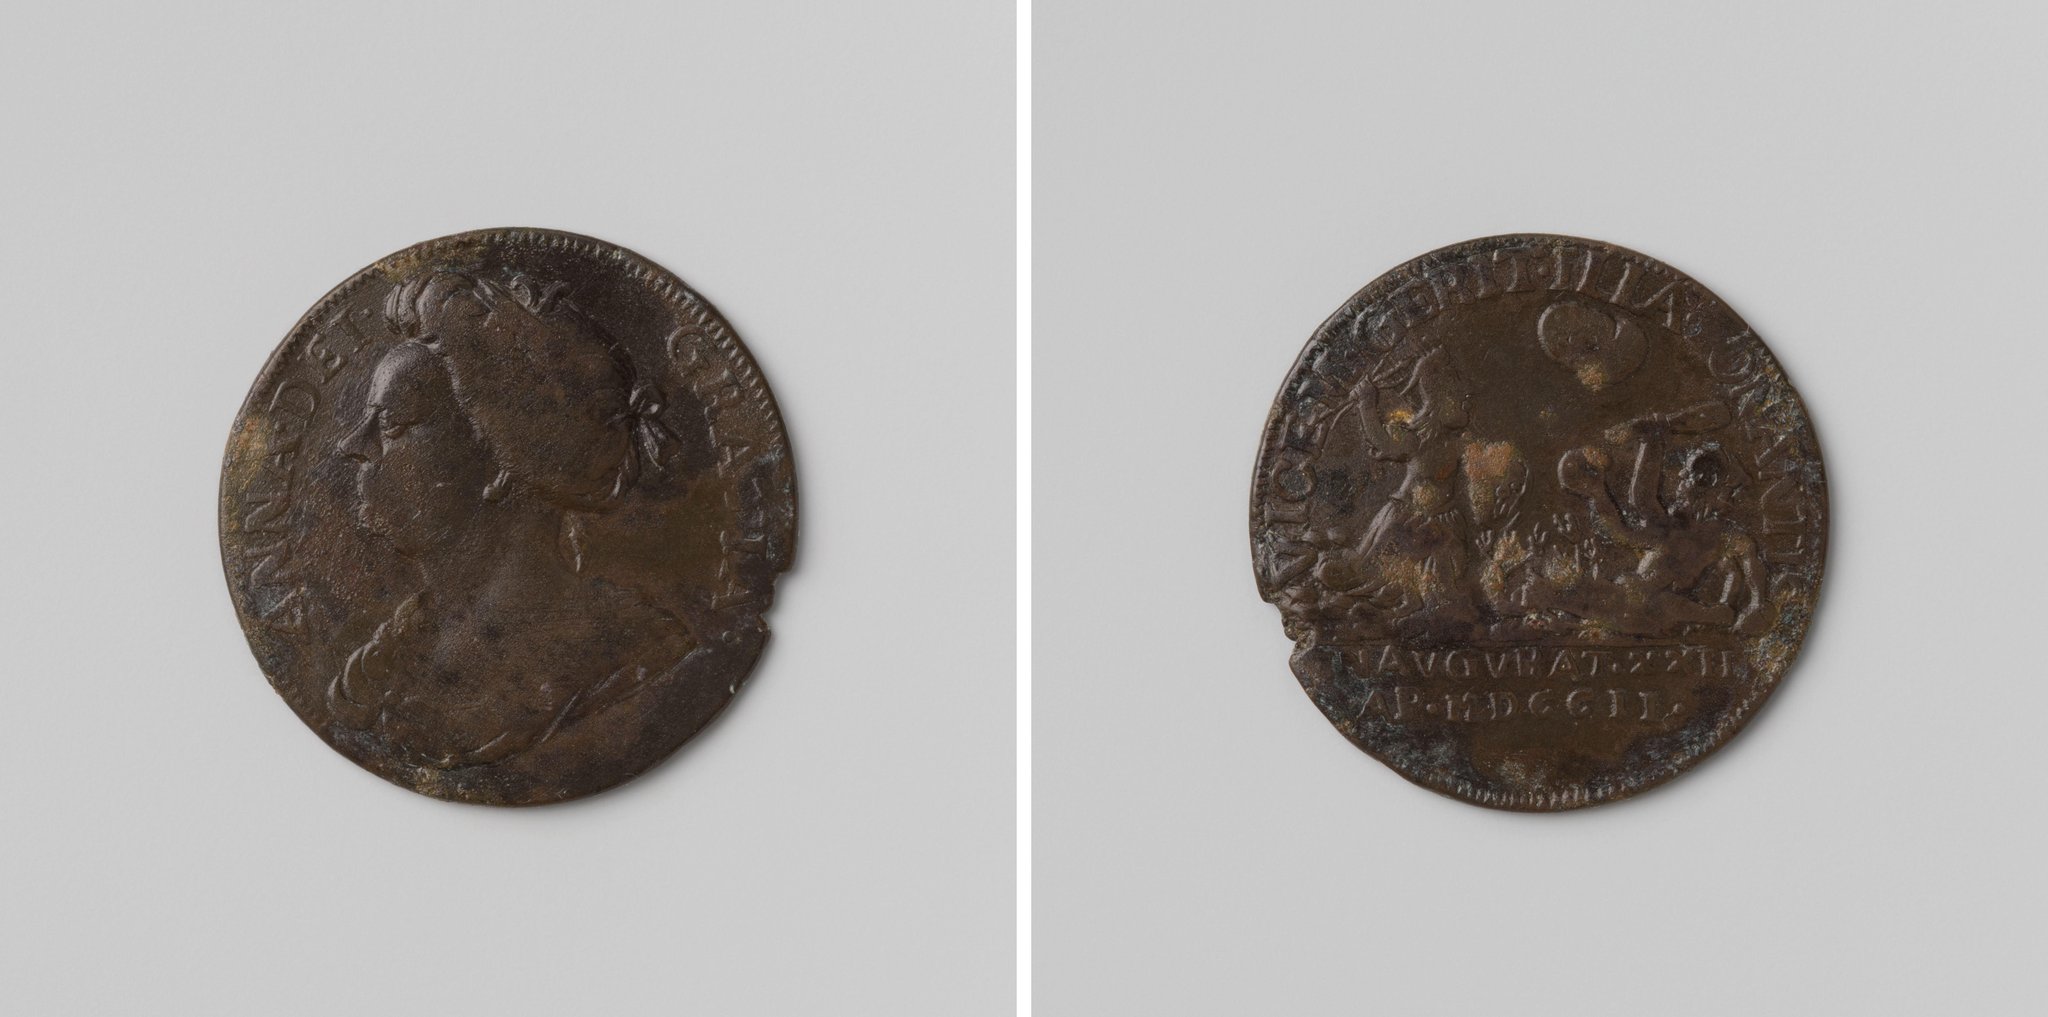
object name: jeton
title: Kroning van Anna tot koningin van Engeland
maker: Anonymous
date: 1702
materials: copper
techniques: striking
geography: london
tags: london, anna stuart (koningin van engeland en schotland)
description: Koperen penning. Voorzijde: borststuk vrouw binnen omschrift. Keerzijde: Anna, in gedaante van Pallas werpt bliksemschicht naar tweekoppig, vierarmig monster binnen omschrift; afsnede: opschrift